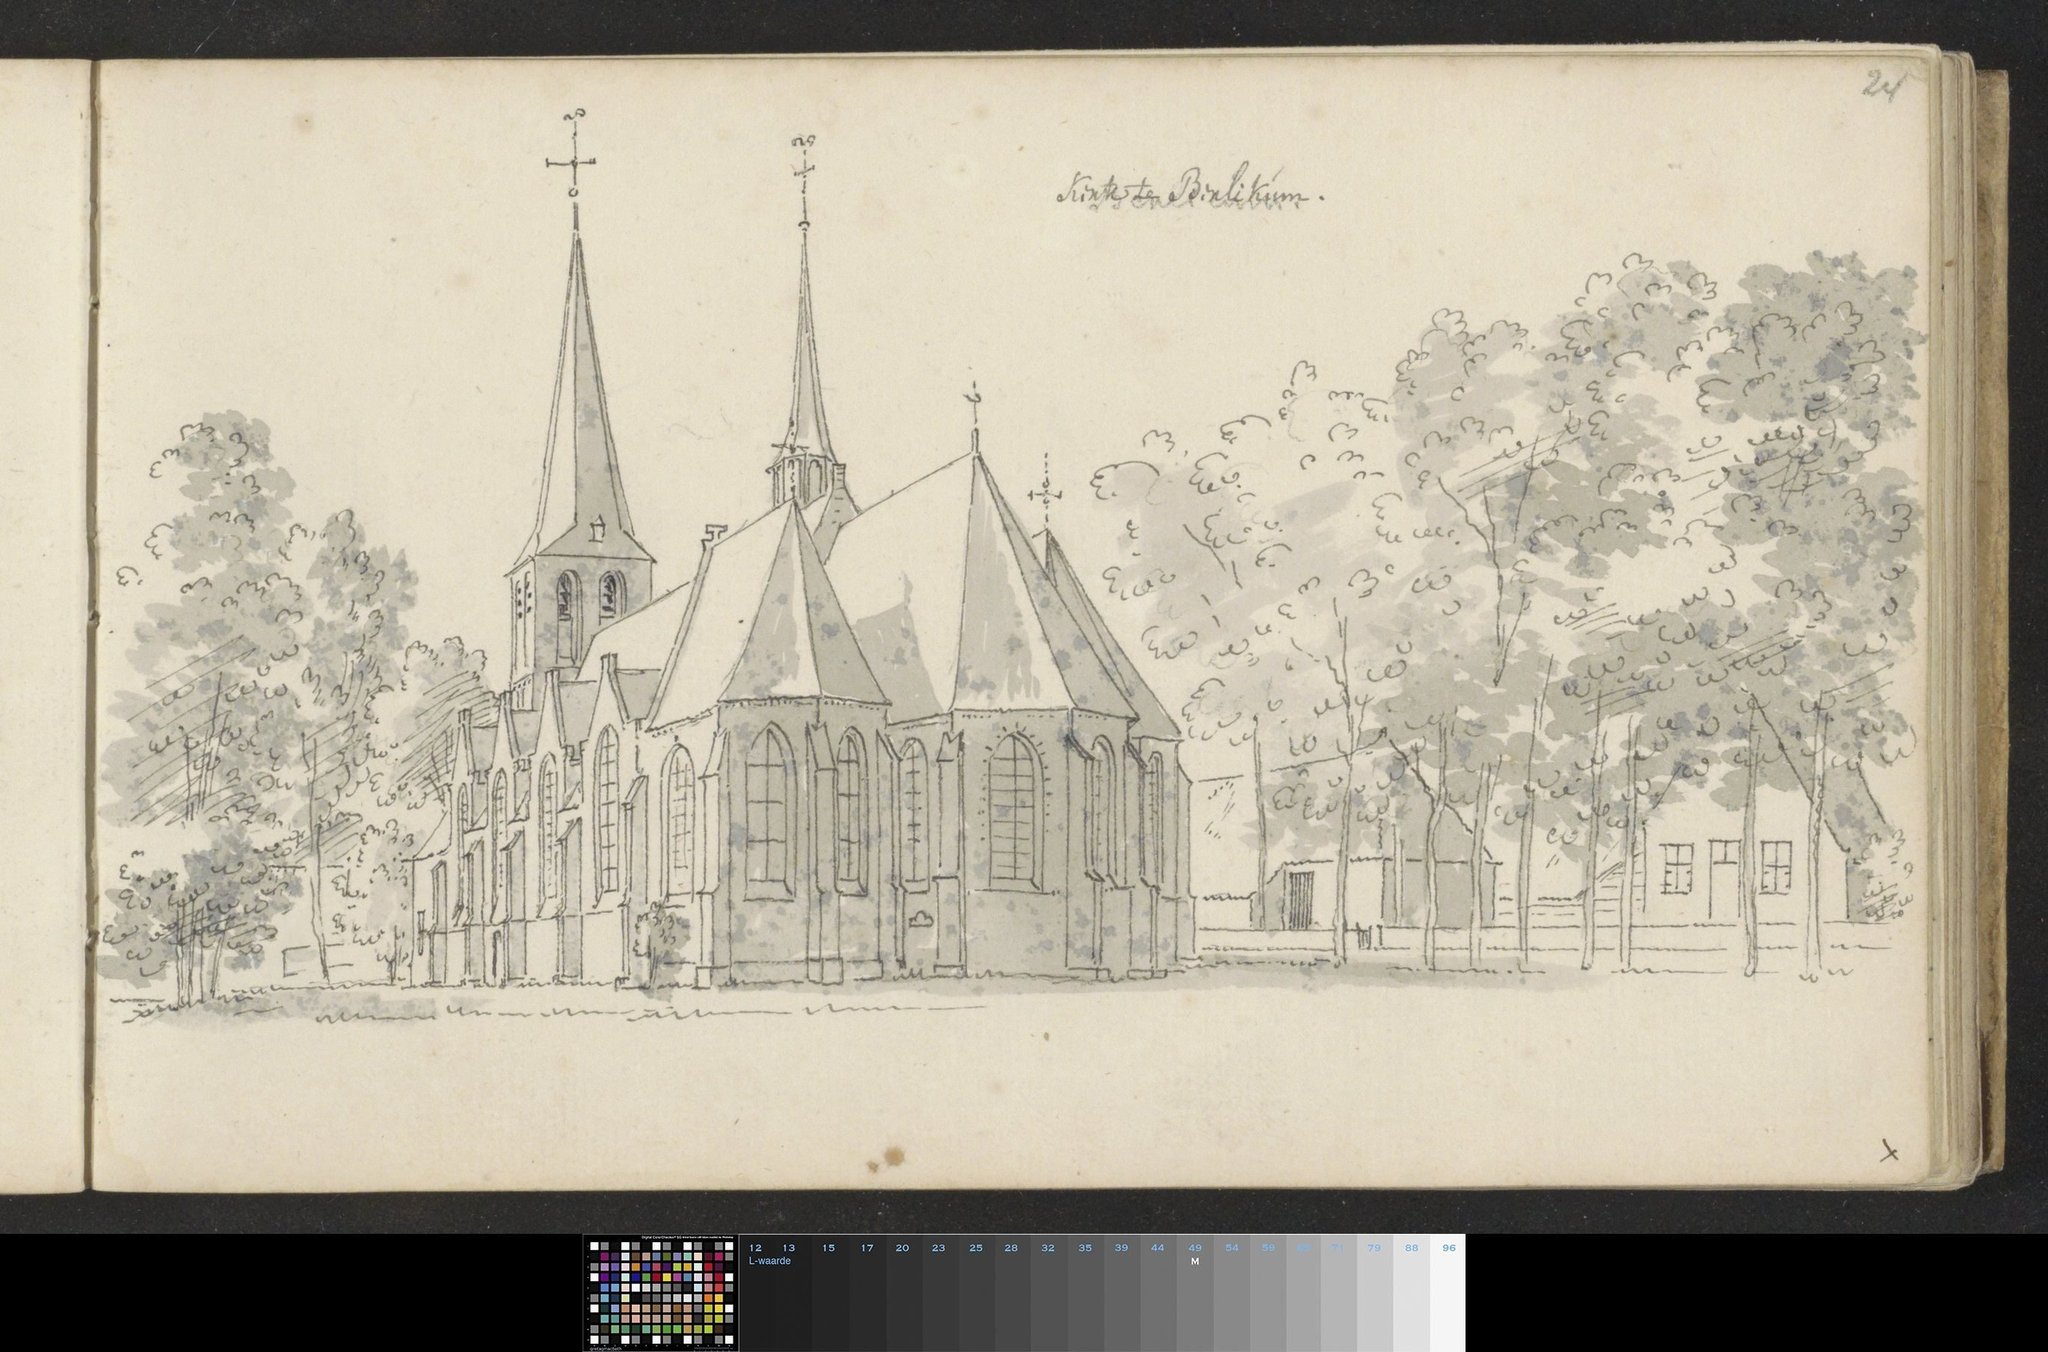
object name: sketchbook leaf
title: Kerk te Berlicum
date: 1701-1759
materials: ink, paper, pencil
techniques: brush, pen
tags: church (exterior)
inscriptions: annotation: ‘Kerk te Berlicum’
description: Blad 24 recto uit een schetsboek met 65 bladen.